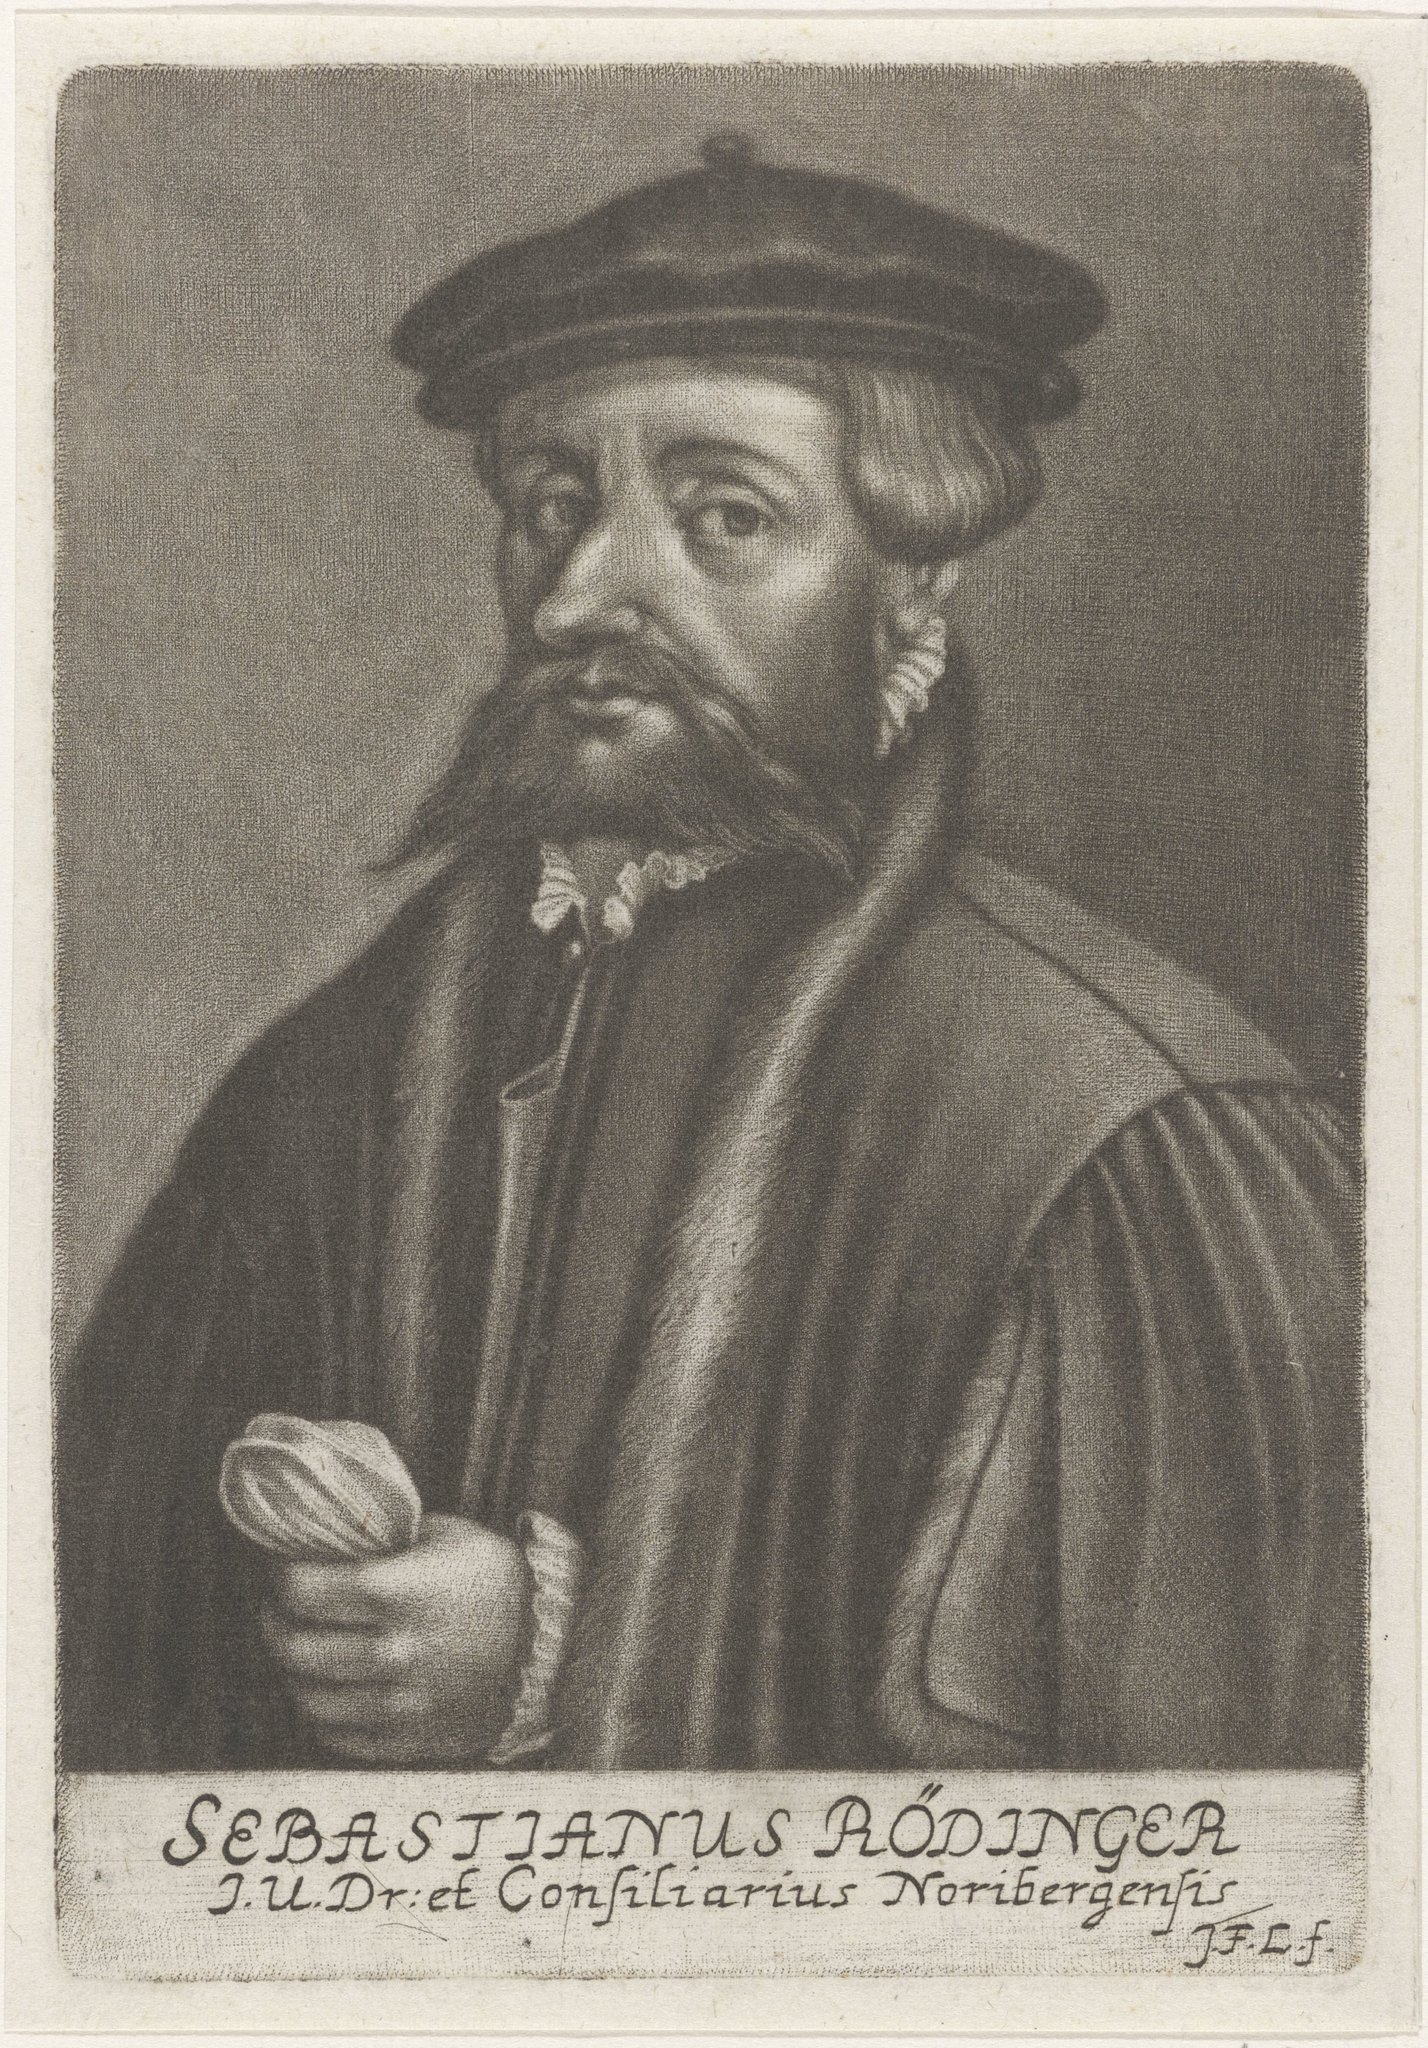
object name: print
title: Portret van de predikant Sebastian Rödinger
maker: johann friedrich leonard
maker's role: print maker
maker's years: 1633-1680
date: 1660-1672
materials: paper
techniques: engraving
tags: sebastian rödinger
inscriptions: collector's mark: Lugt 2228